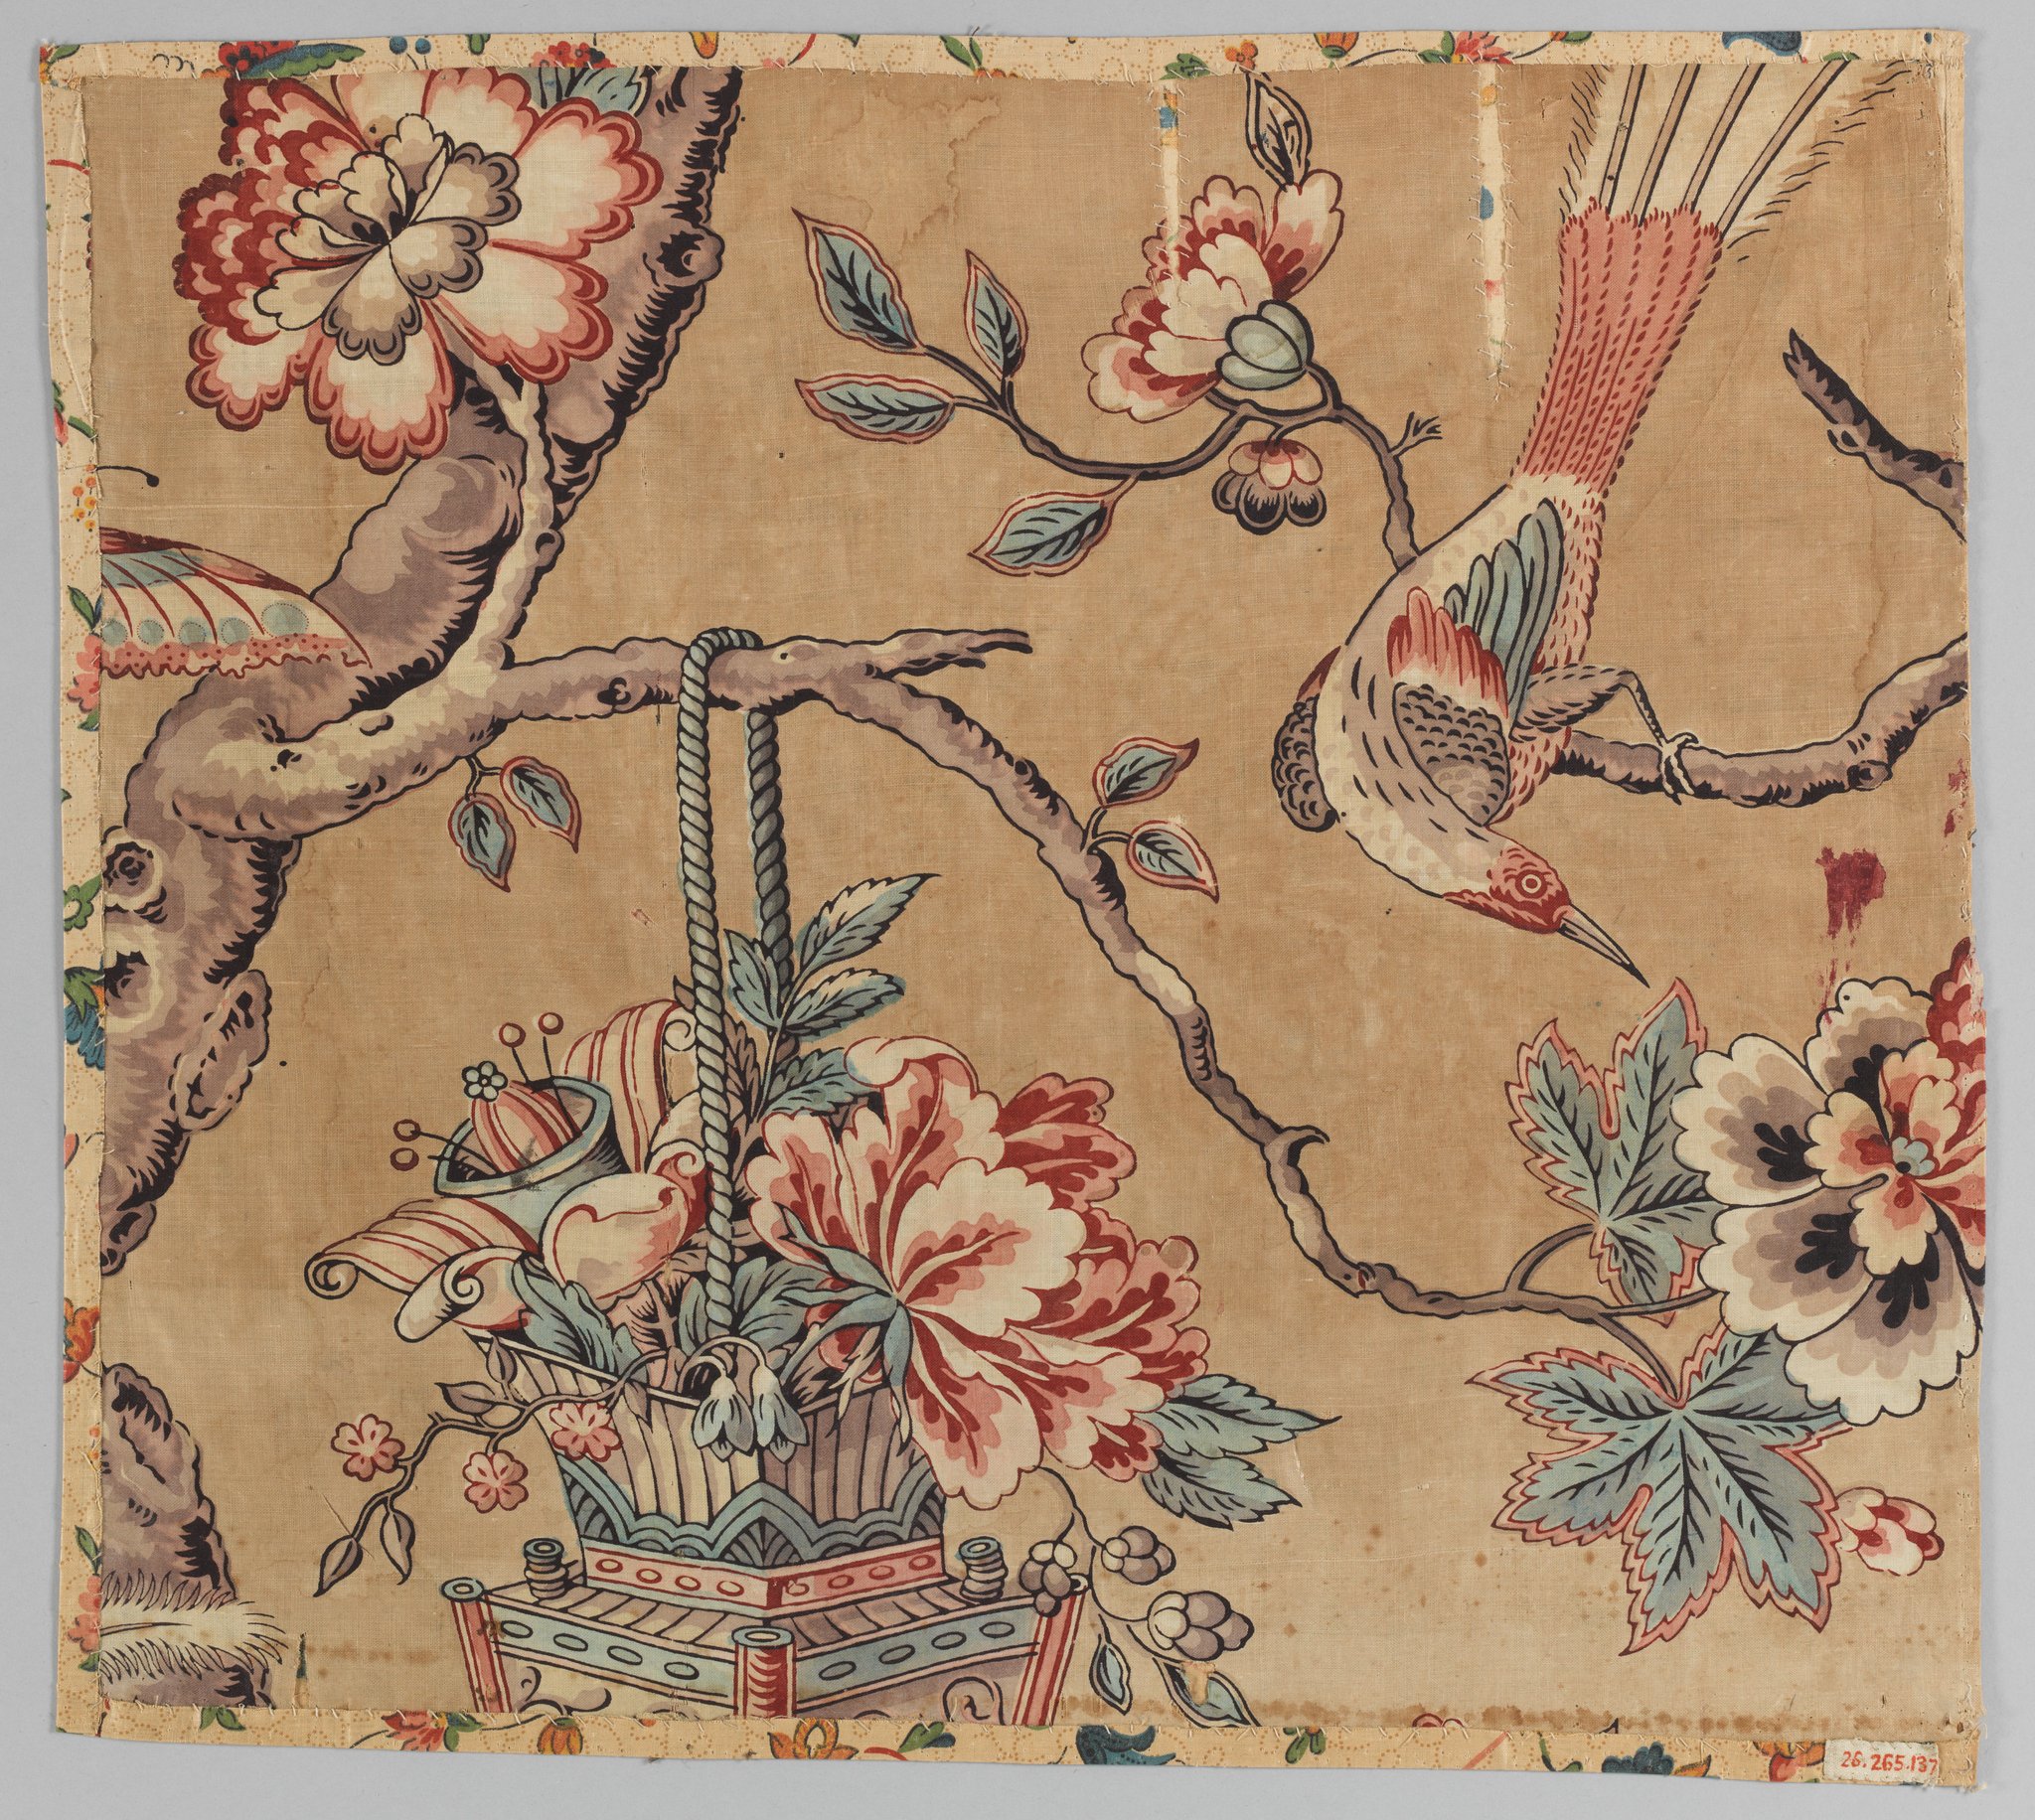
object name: piece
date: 1825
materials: cotton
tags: birds,flowers